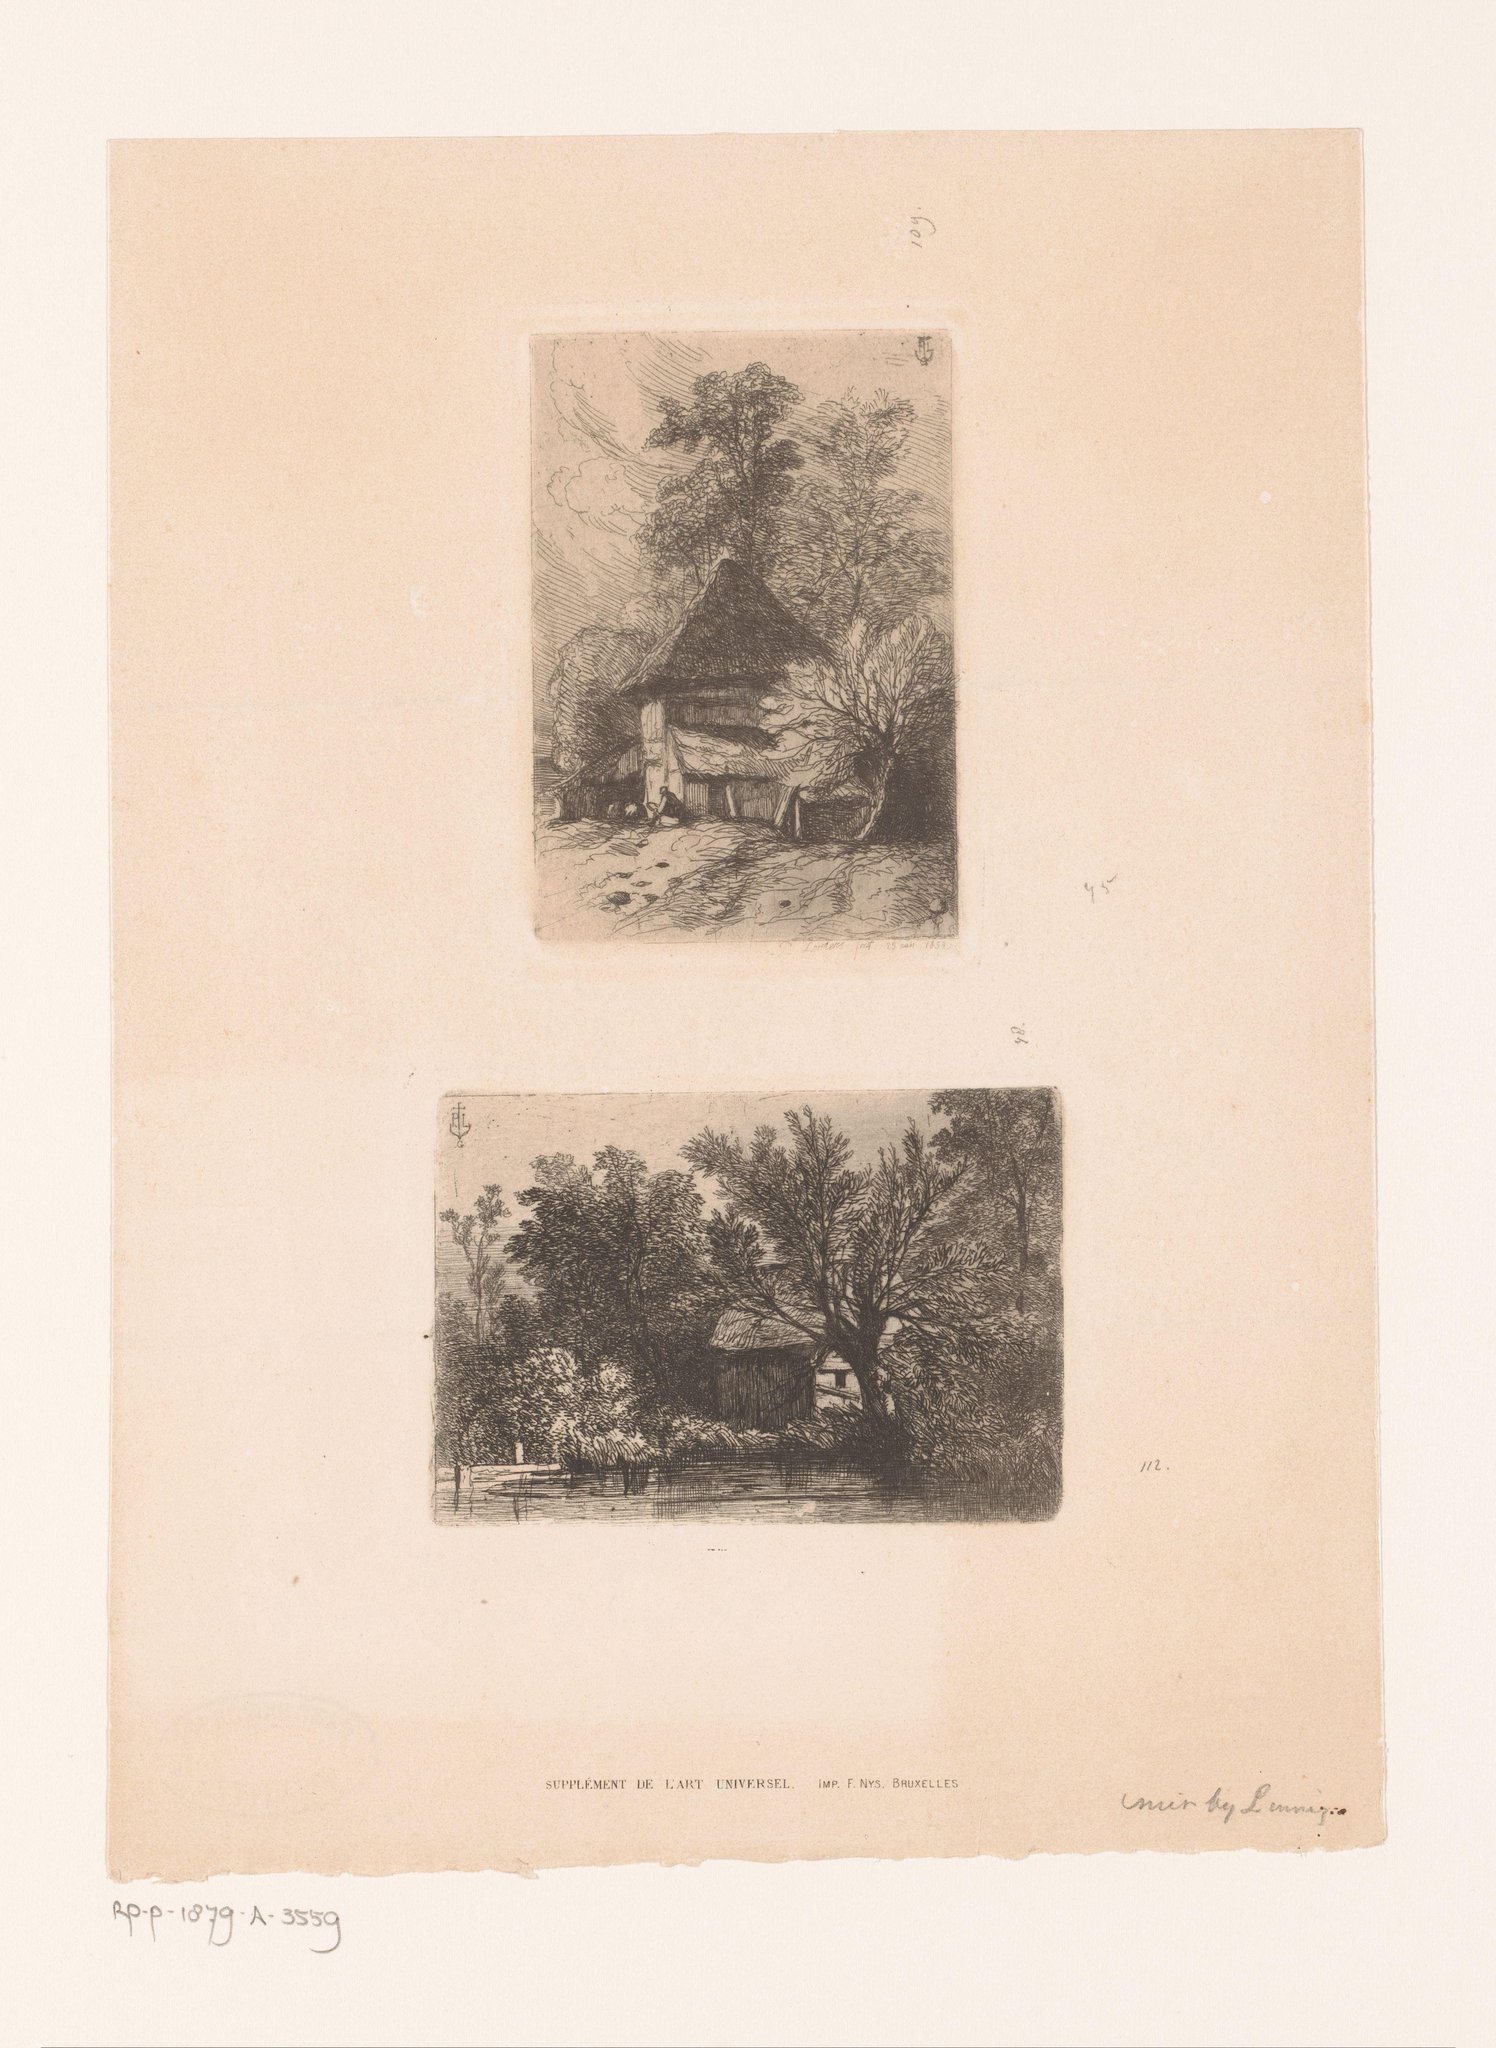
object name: print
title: Twee landschappen met kleine rietgedekte gebouwen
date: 1854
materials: paper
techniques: etching, intaglio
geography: brussels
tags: farm or solitary house in landscape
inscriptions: collector's mark: Lugt 3073, collector's mark: Lugt 2228